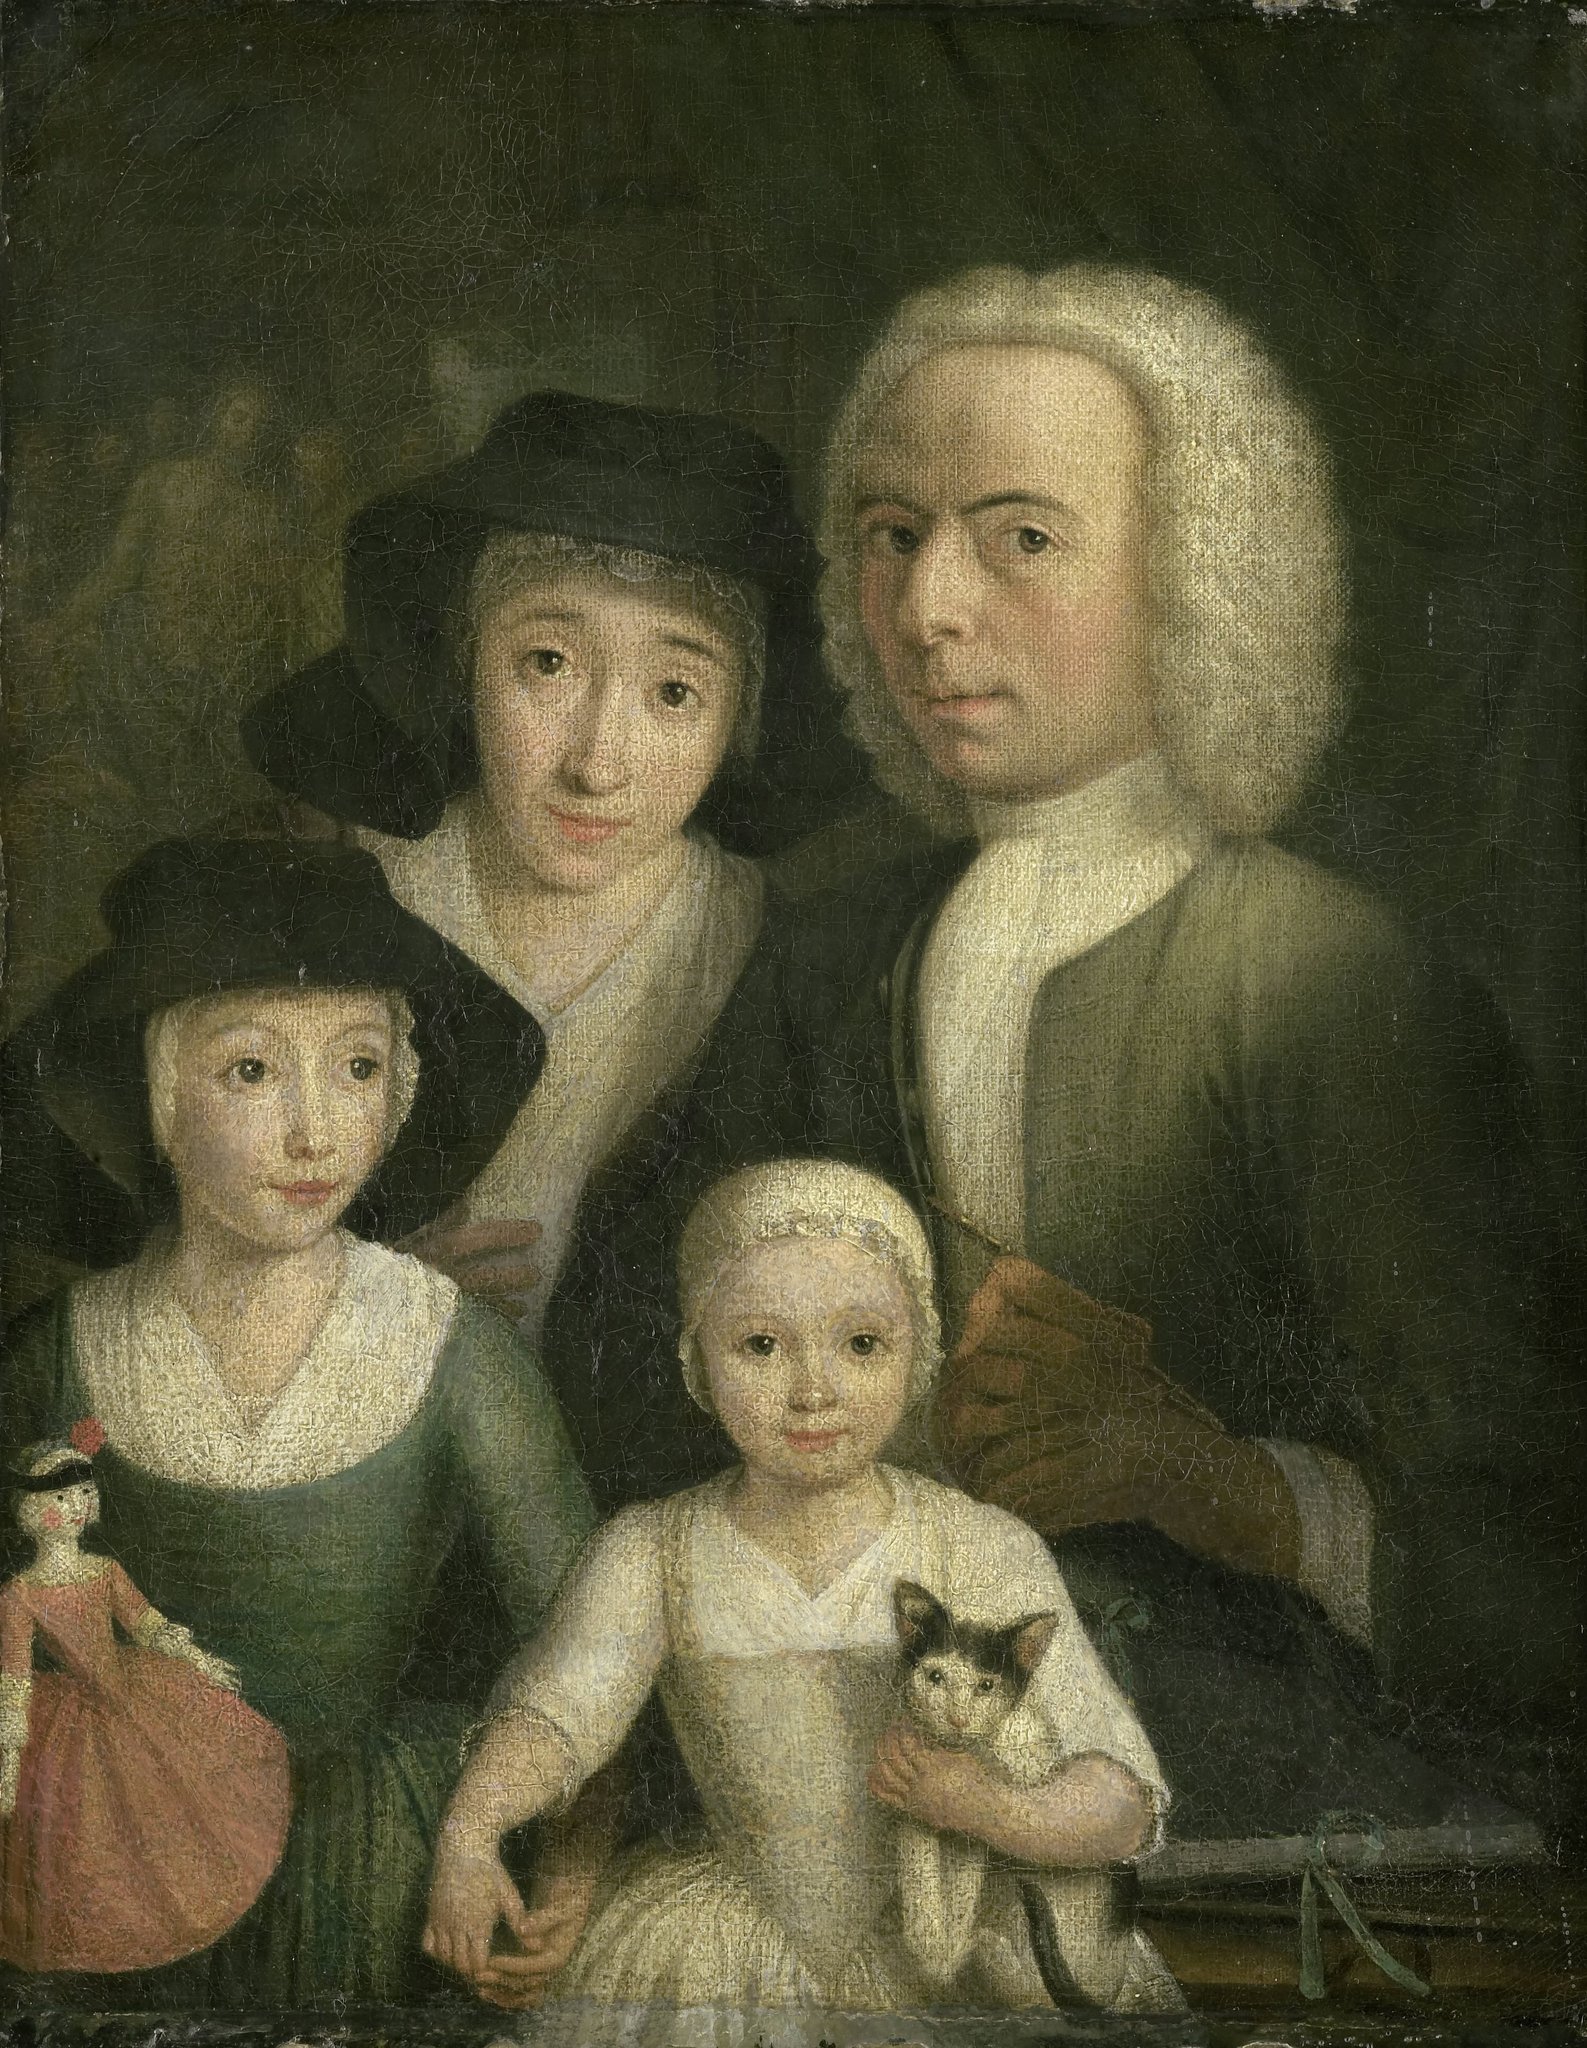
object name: painting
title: Self Portrait with his Wife Sanneke van Bommel and their two Children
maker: hendrik spilman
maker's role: draughtsman, painter, print maker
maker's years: 1721-1784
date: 1761-1784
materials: canvas, oil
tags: amsterdam, painter, print maker, draughtsman, hendrik spilman, cat, historical persons - bb - woman, family group, especially parents with their child(ren), historical persons, portrait, self-portrait of painter, (playing with) dolls, portrait, self-portrait of artist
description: Zelfportret van de schilder Hendrik Spilman (1721-1784) met zijn vrouw Sanneke van Bommel (geb. 1741) en hun twee kinderen. De man heeft een tekenpen in de rechterhand en leunt met de linker elleboog op een kunstboek. De jongste dochter heeft een kat in de hand, de oudste dochter een pop.